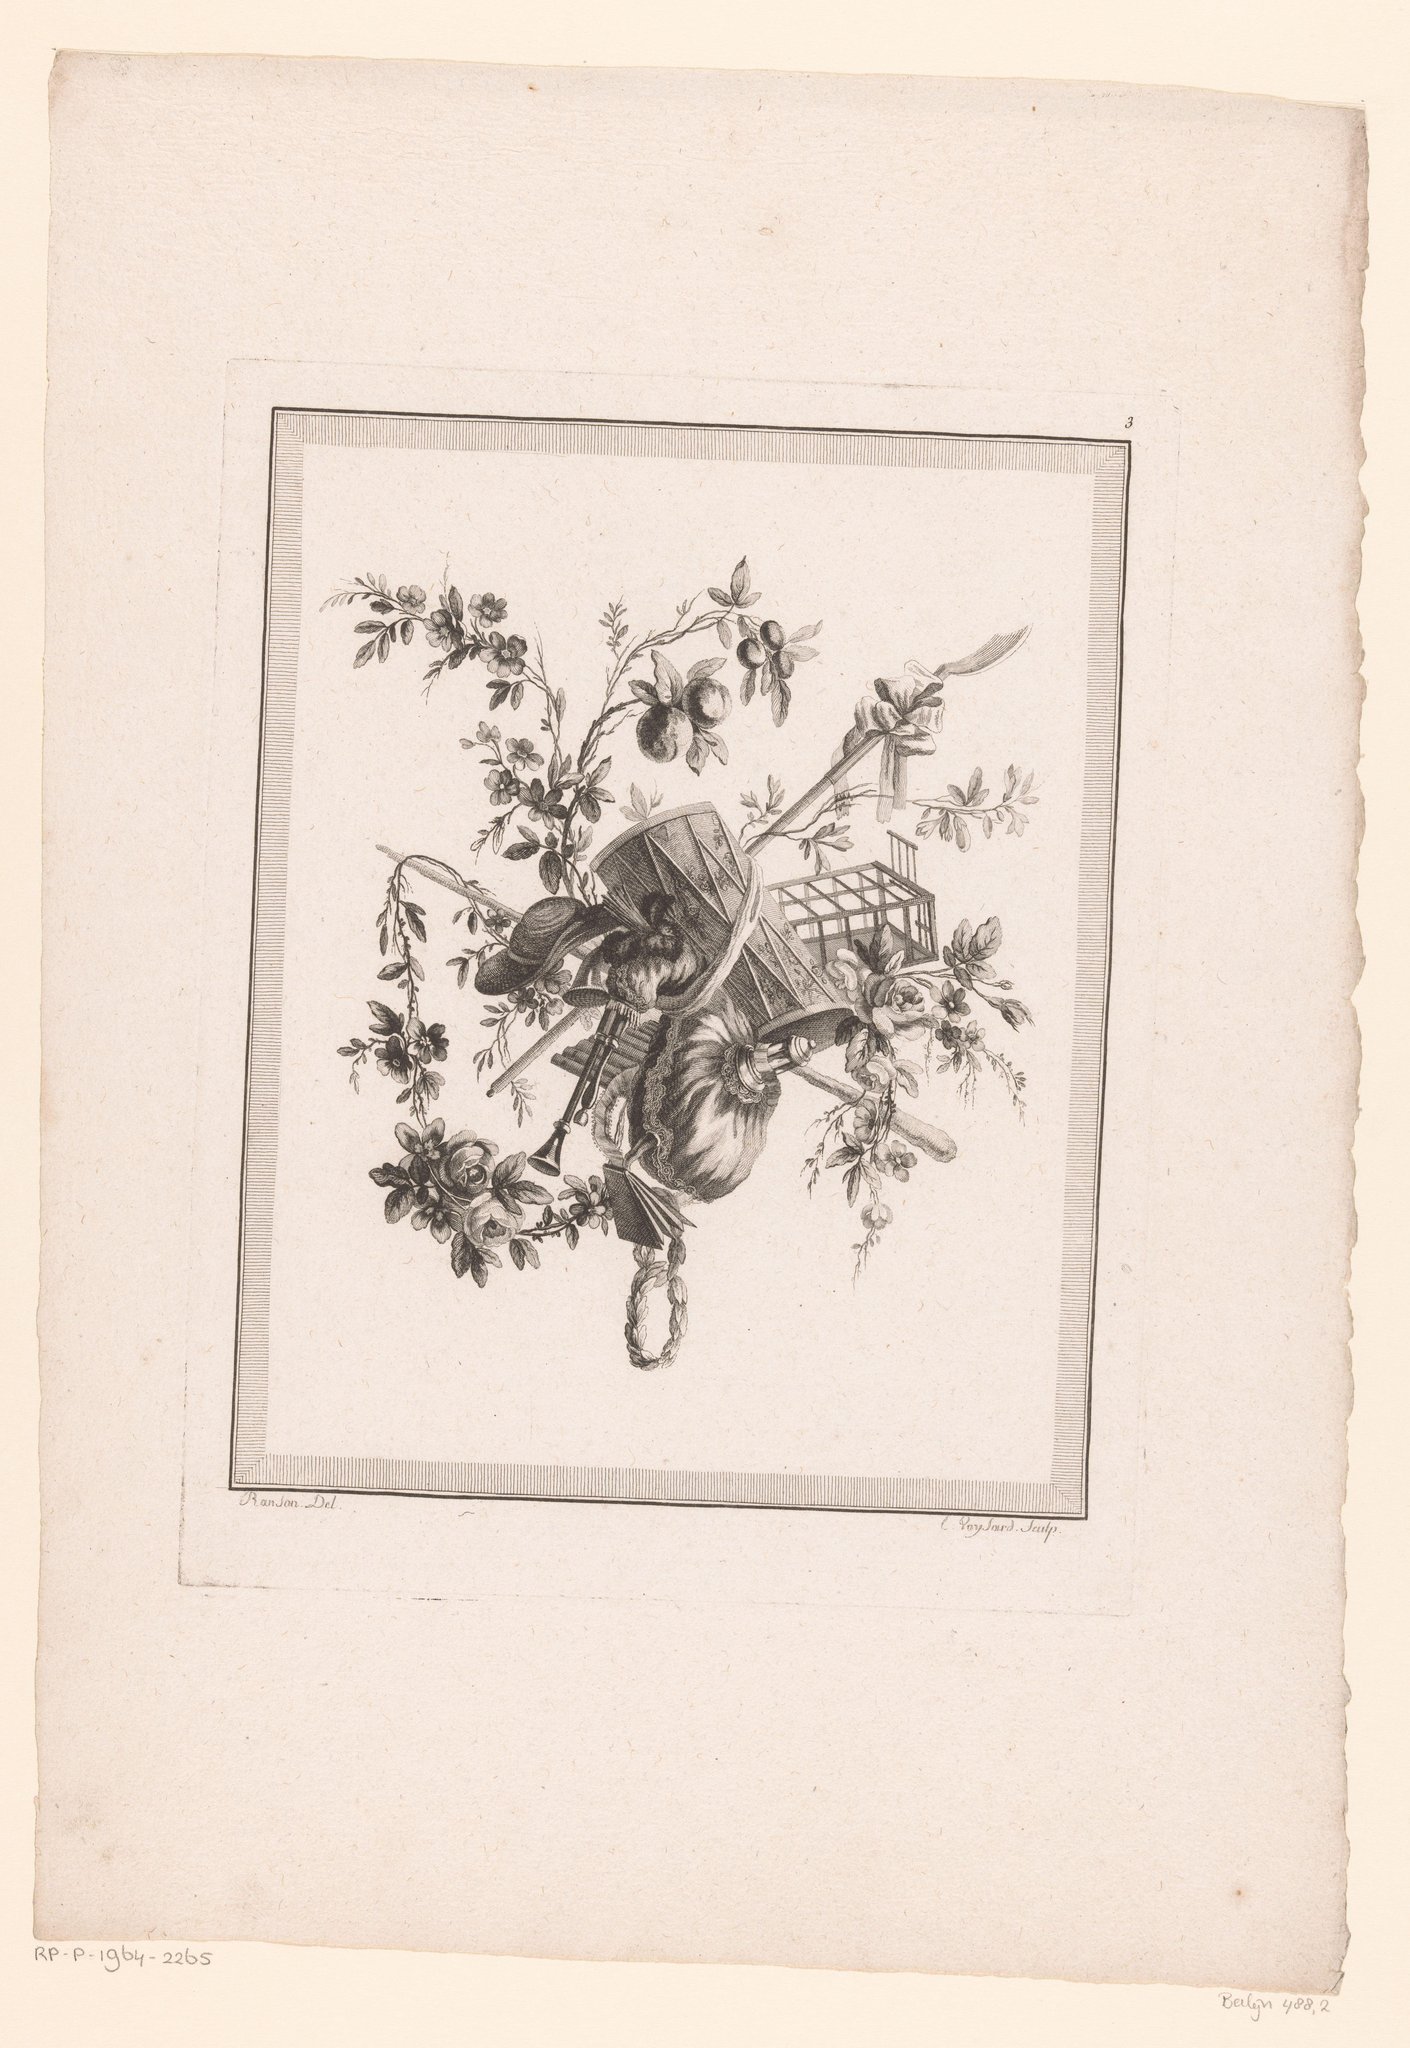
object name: print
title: Trofee met herdersattributen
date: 1778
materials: paper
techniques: etching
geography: paris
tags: trophy, i.e.: decorative arrangement of symbolic or typical objects ~ ornament, herding, herdsman, herdswoman, shepherd, shepherdess, cowherd, etc.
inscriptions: collector's mark: Lugt 2228, collector's mark: Lugt 2760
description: Een trofee met herdersattributen zoals een herdersstaf en -hoed, een lege vogelkooi, een trom en een doedelzak.